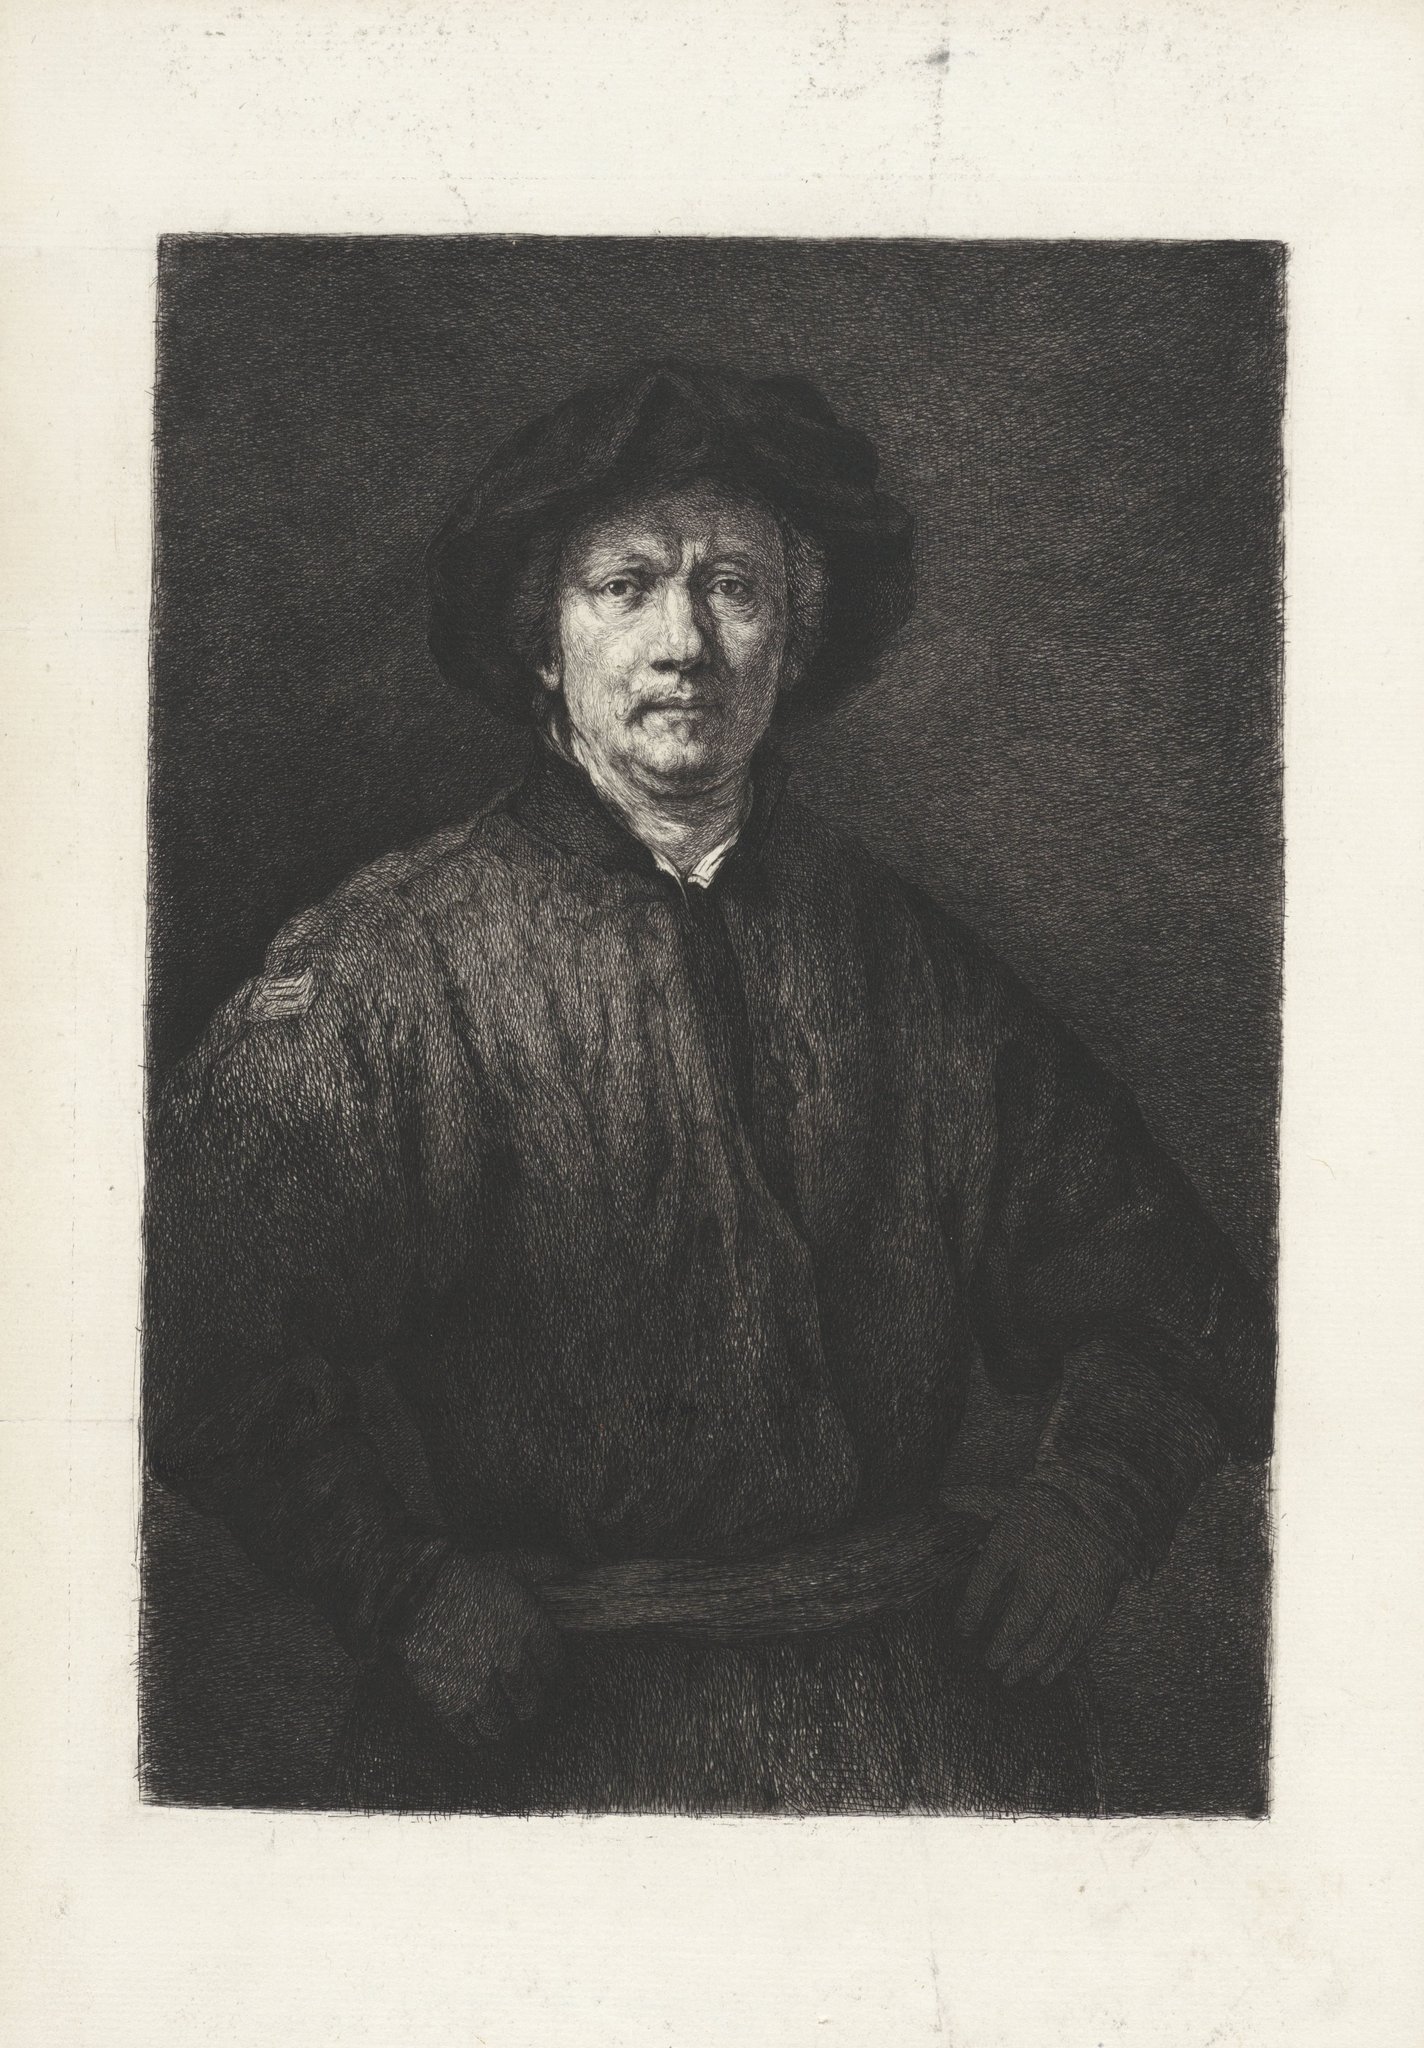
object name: print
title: Portret van Rembrandt Harmensz. van Rijn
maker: Anonymous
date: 1652-1719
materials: paper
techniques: etching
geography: northern netherlands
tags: leiden, amsterdam, painter, print maker, draughtsman, rembrandt van rijn, portrait, self-portrait of artist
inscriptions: collector's mark: Lugt 2228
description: Portret van Rembrandt Harmensz. van Rijn naar zijn zelfportret. Hij heeft zijn handen in zijn zij en draagt een muts of baret.